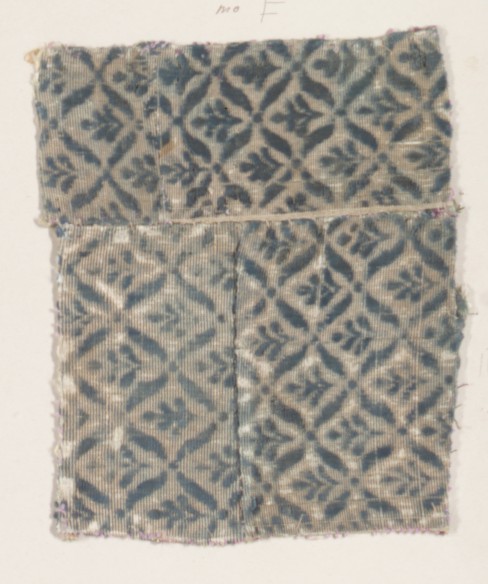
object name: fragment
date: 1701-1800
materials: silk